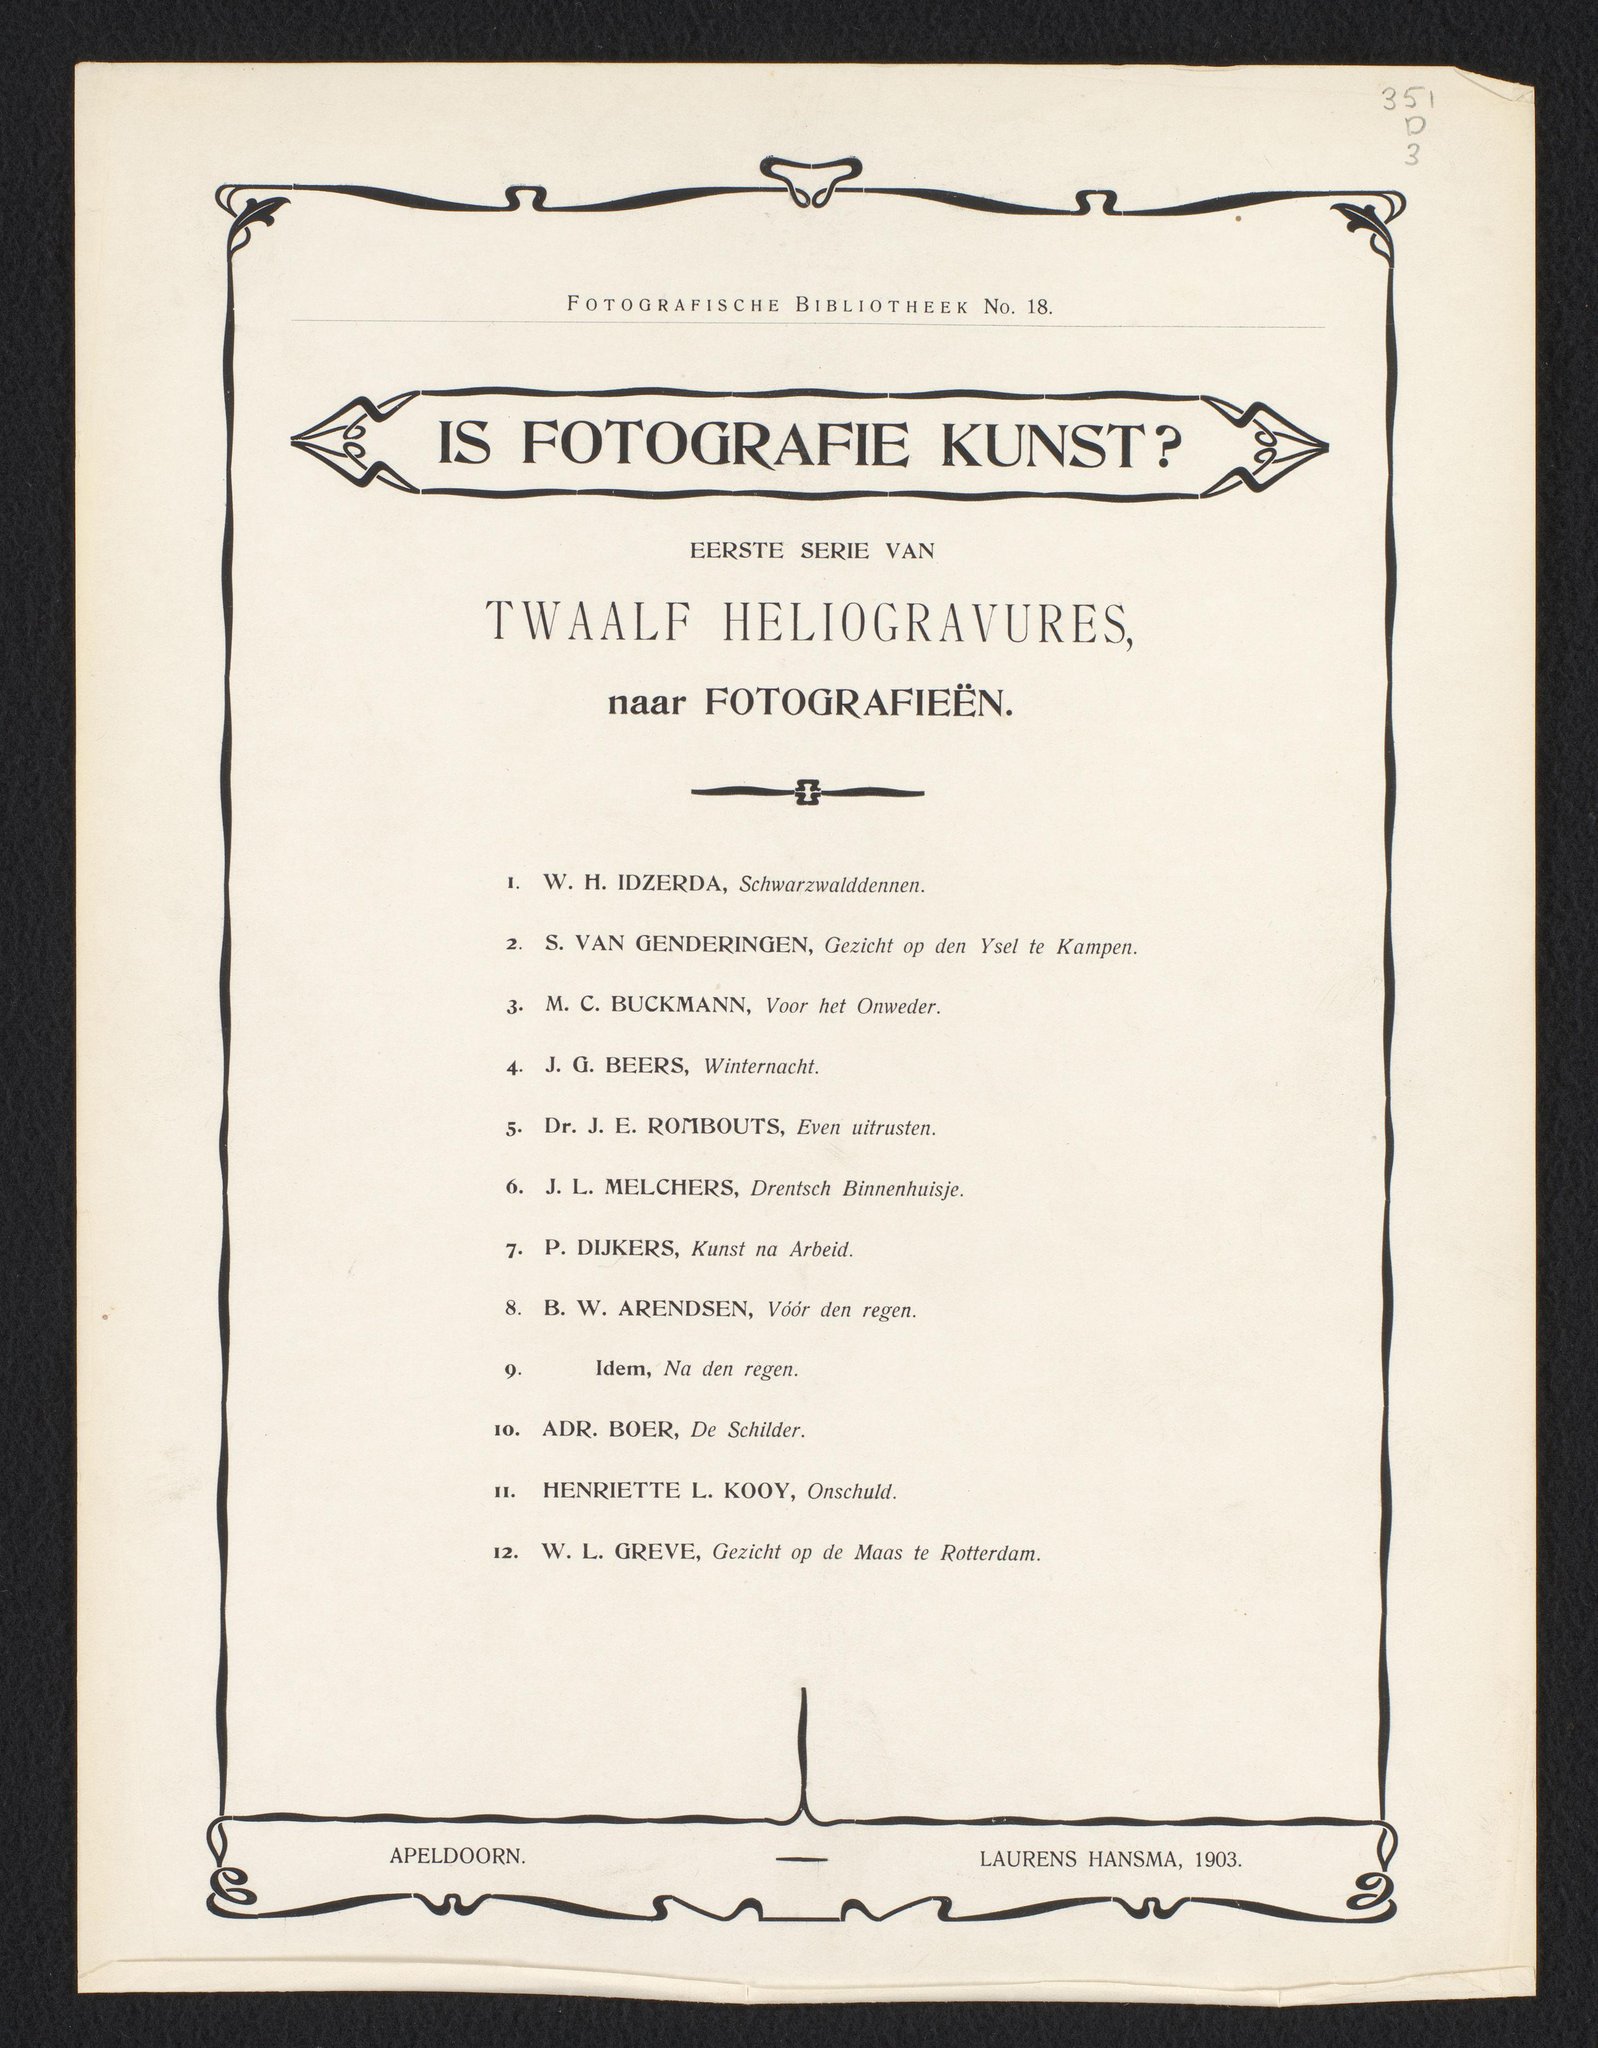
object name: wrapper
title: Is fotografie kunst?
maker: laurens hansma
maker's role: publisher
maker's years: 1860-1920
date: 1903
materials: cardboard, paper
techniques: photoaquatint, printing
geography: apeldoorn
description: Omslag met 11 heliogravures van verschillende fotografen; de 12de afbeelding ontbreekt in dit exemplaar.